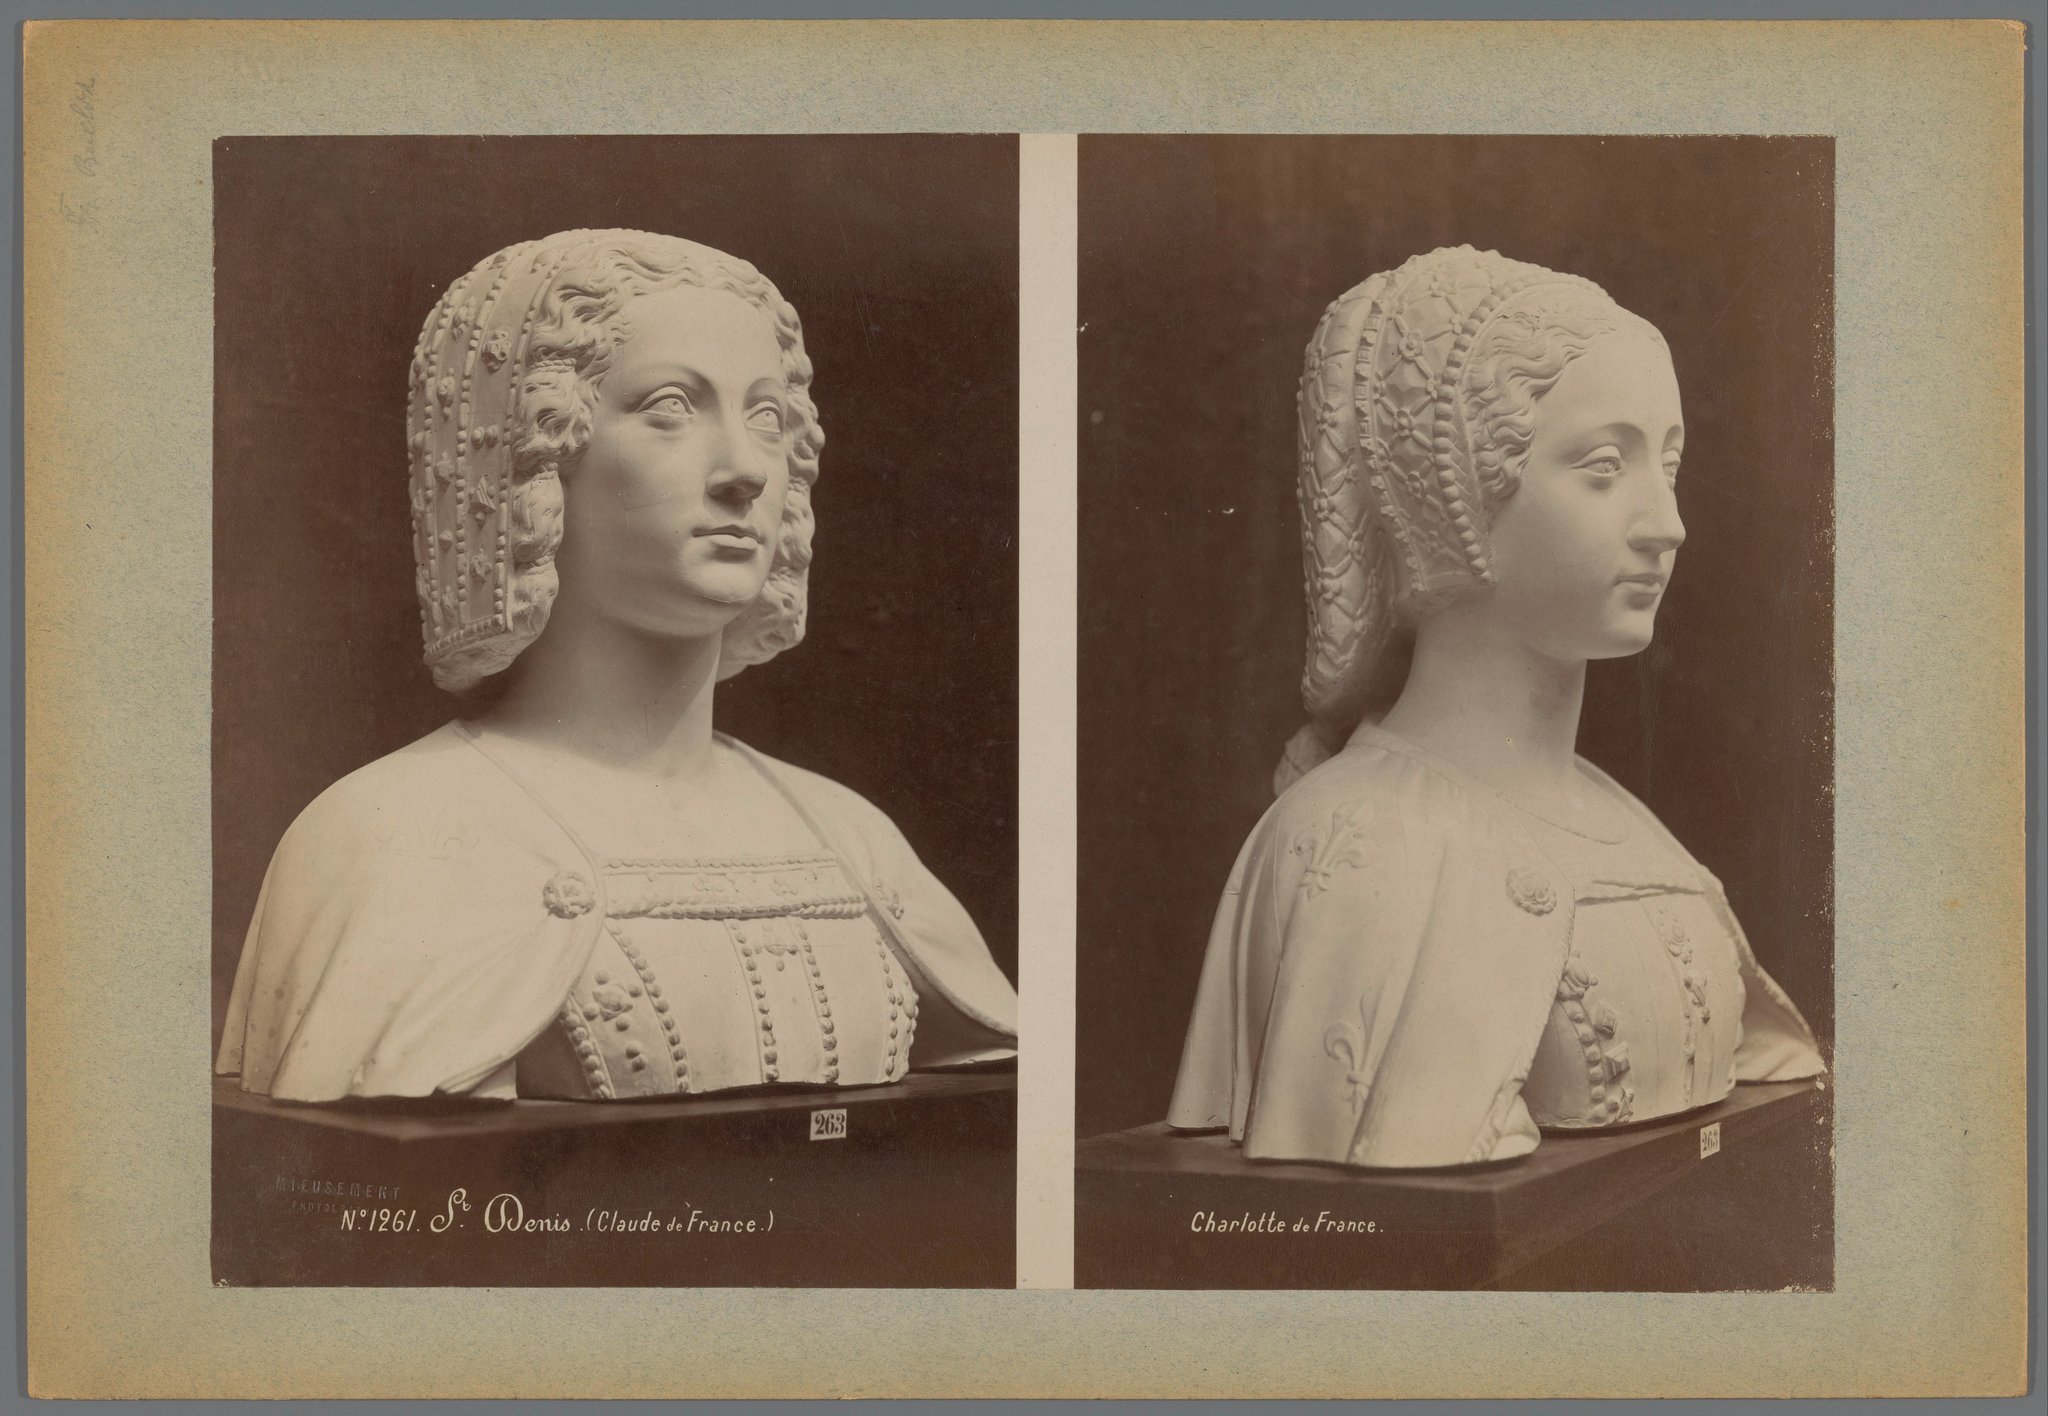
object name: photograph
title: St. Denis. (Claude de France.) Charlotte de France.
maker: séraphin-médéric mieusement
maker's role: fotograaf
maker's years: 1840-1905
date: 1875-1900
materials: cardboard, photographic support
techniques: albumen print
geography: palais du trocadéro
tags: historical persons - bb - woman, permanent exhibition, museum, sculpture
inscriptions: name: ‘KUNSTBOEKHANDEL J. A. G. DE LEUR PHOTOGRAAF - UITGEVER HUIGENSPARK, 40b. DEN HAAG.’, number: ‘No. 1261.’, inscription: ‘MONUMENTS HISTORIQUES’, name: ‘MIEUSEMENT PHOTOGRAPHE’, collector's mark: Lugt 3937